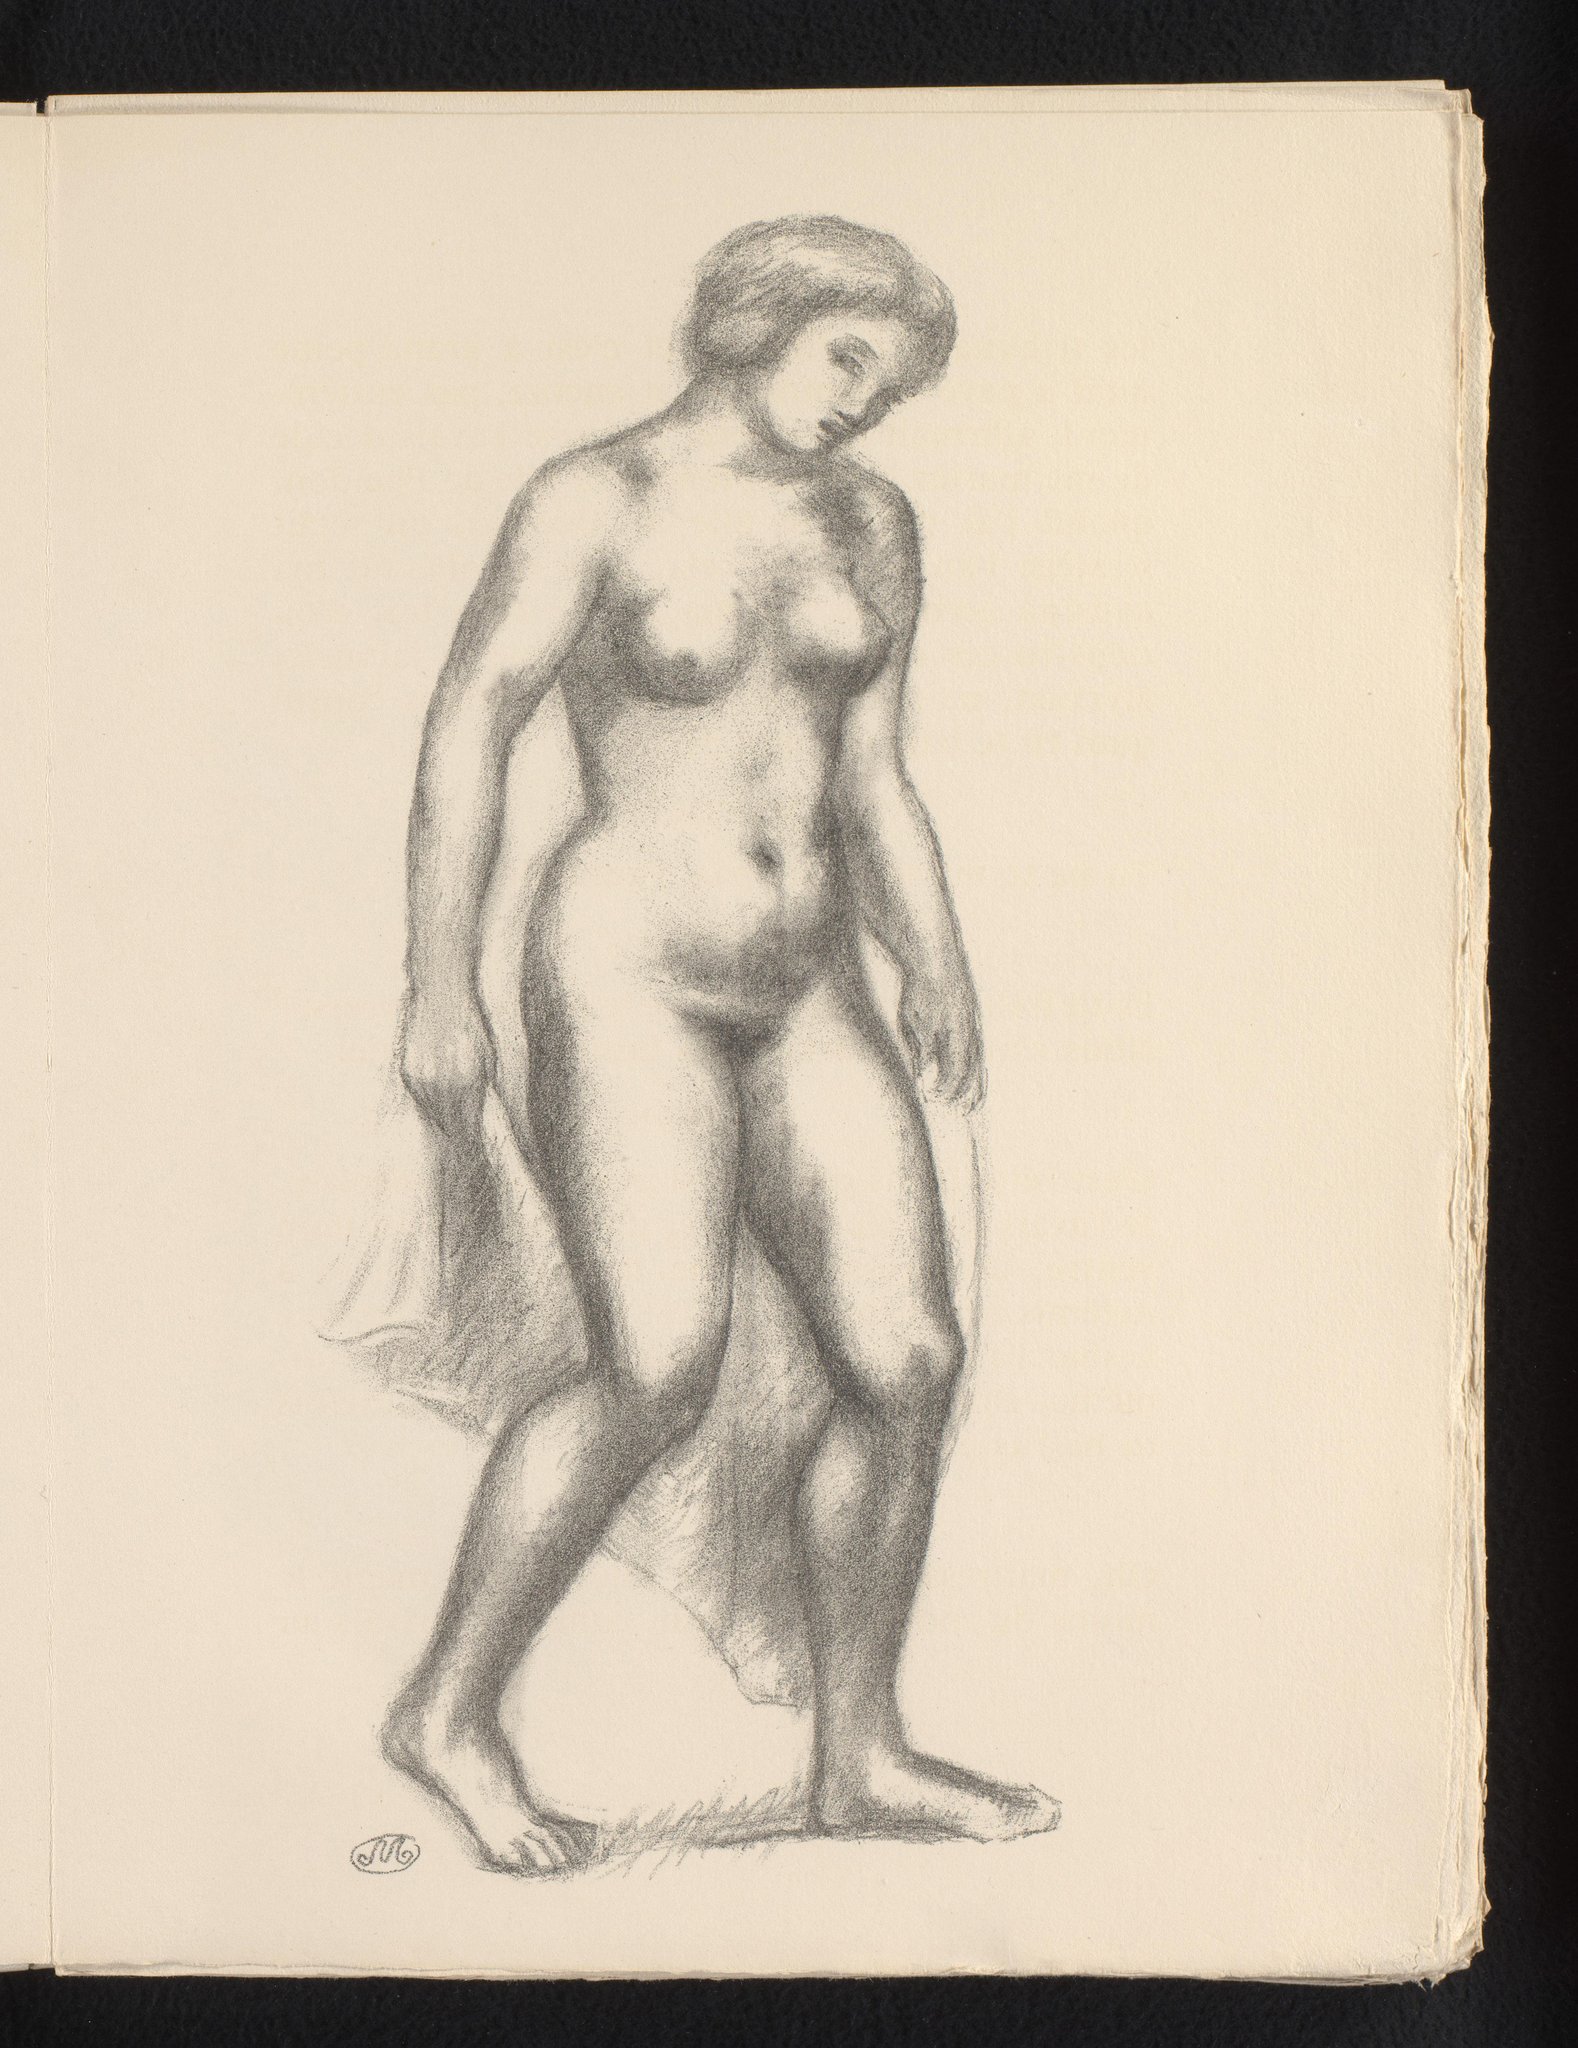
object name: book illustration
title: Liggende naakte vrouw, op de rug gezien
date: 1948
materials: paper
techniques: letterpress printing, lithograph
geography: paris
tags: woman (showing herself) undressed, quasi-nude, standing figure - aa - female human figure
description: Prent uit: Lucianus van Samosata. Dialogues des Courtisanes. [Vertaald uit het Grieks door] Charles Astruc. Parijs: s.n., 1948, p. 9.